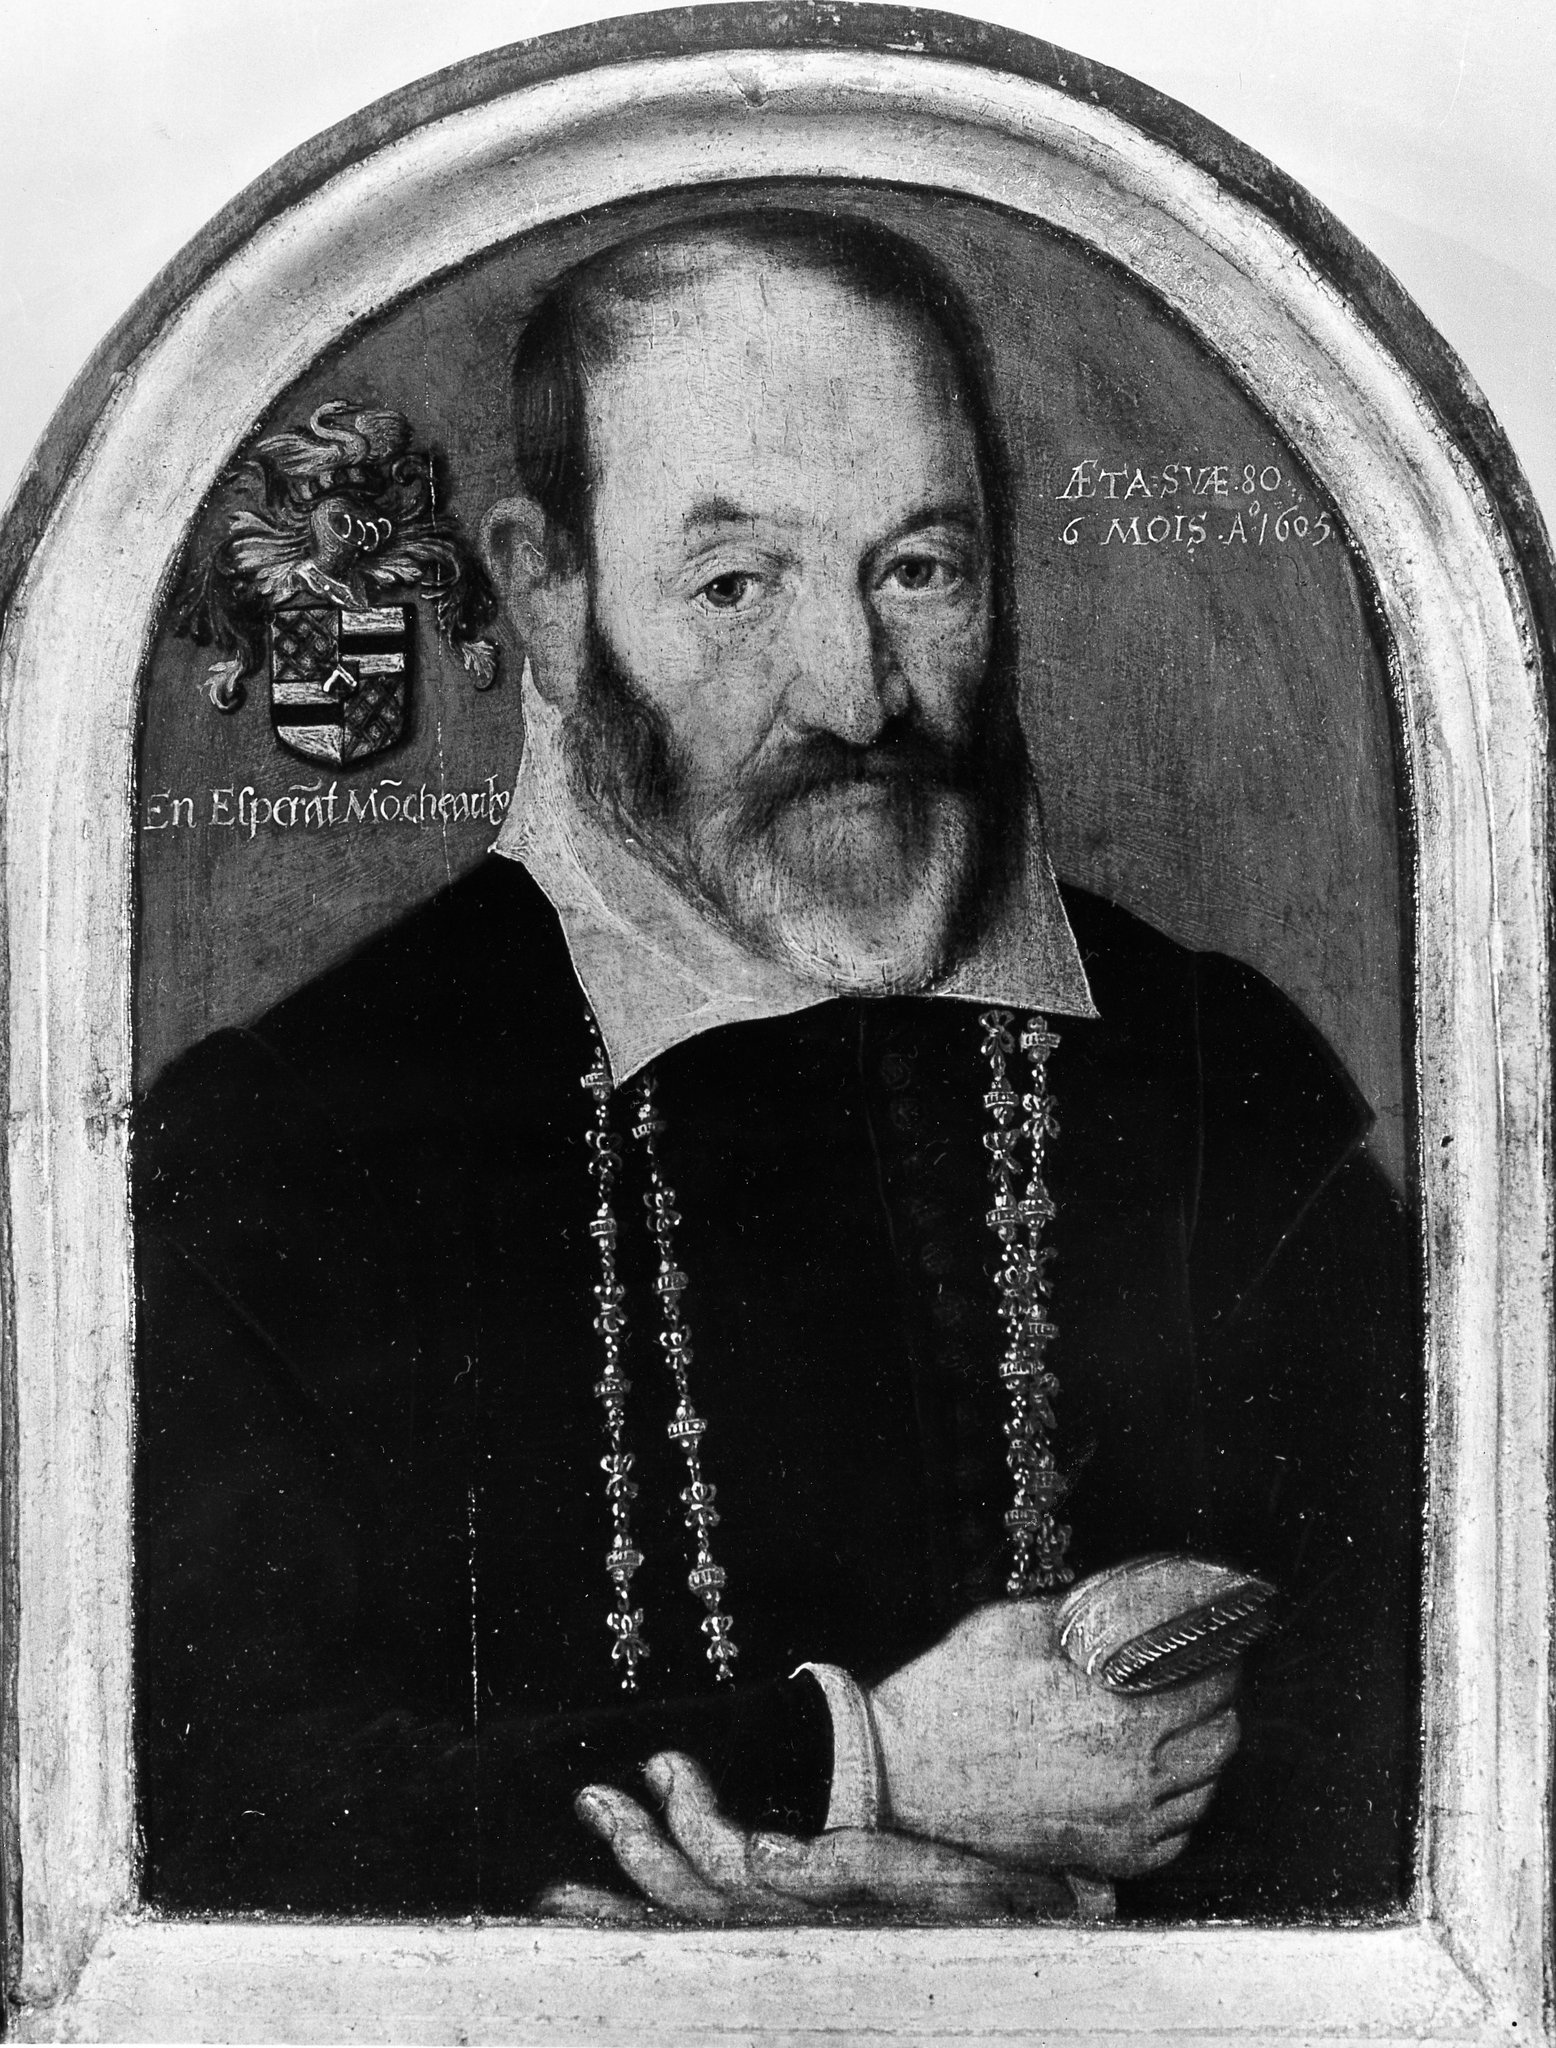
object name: painting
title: Portrait of a Man of the Moncheaux Family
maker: northern french painter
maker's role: artist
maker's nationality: french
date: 1605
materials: oil, wood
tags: men,portraits,coat of arms